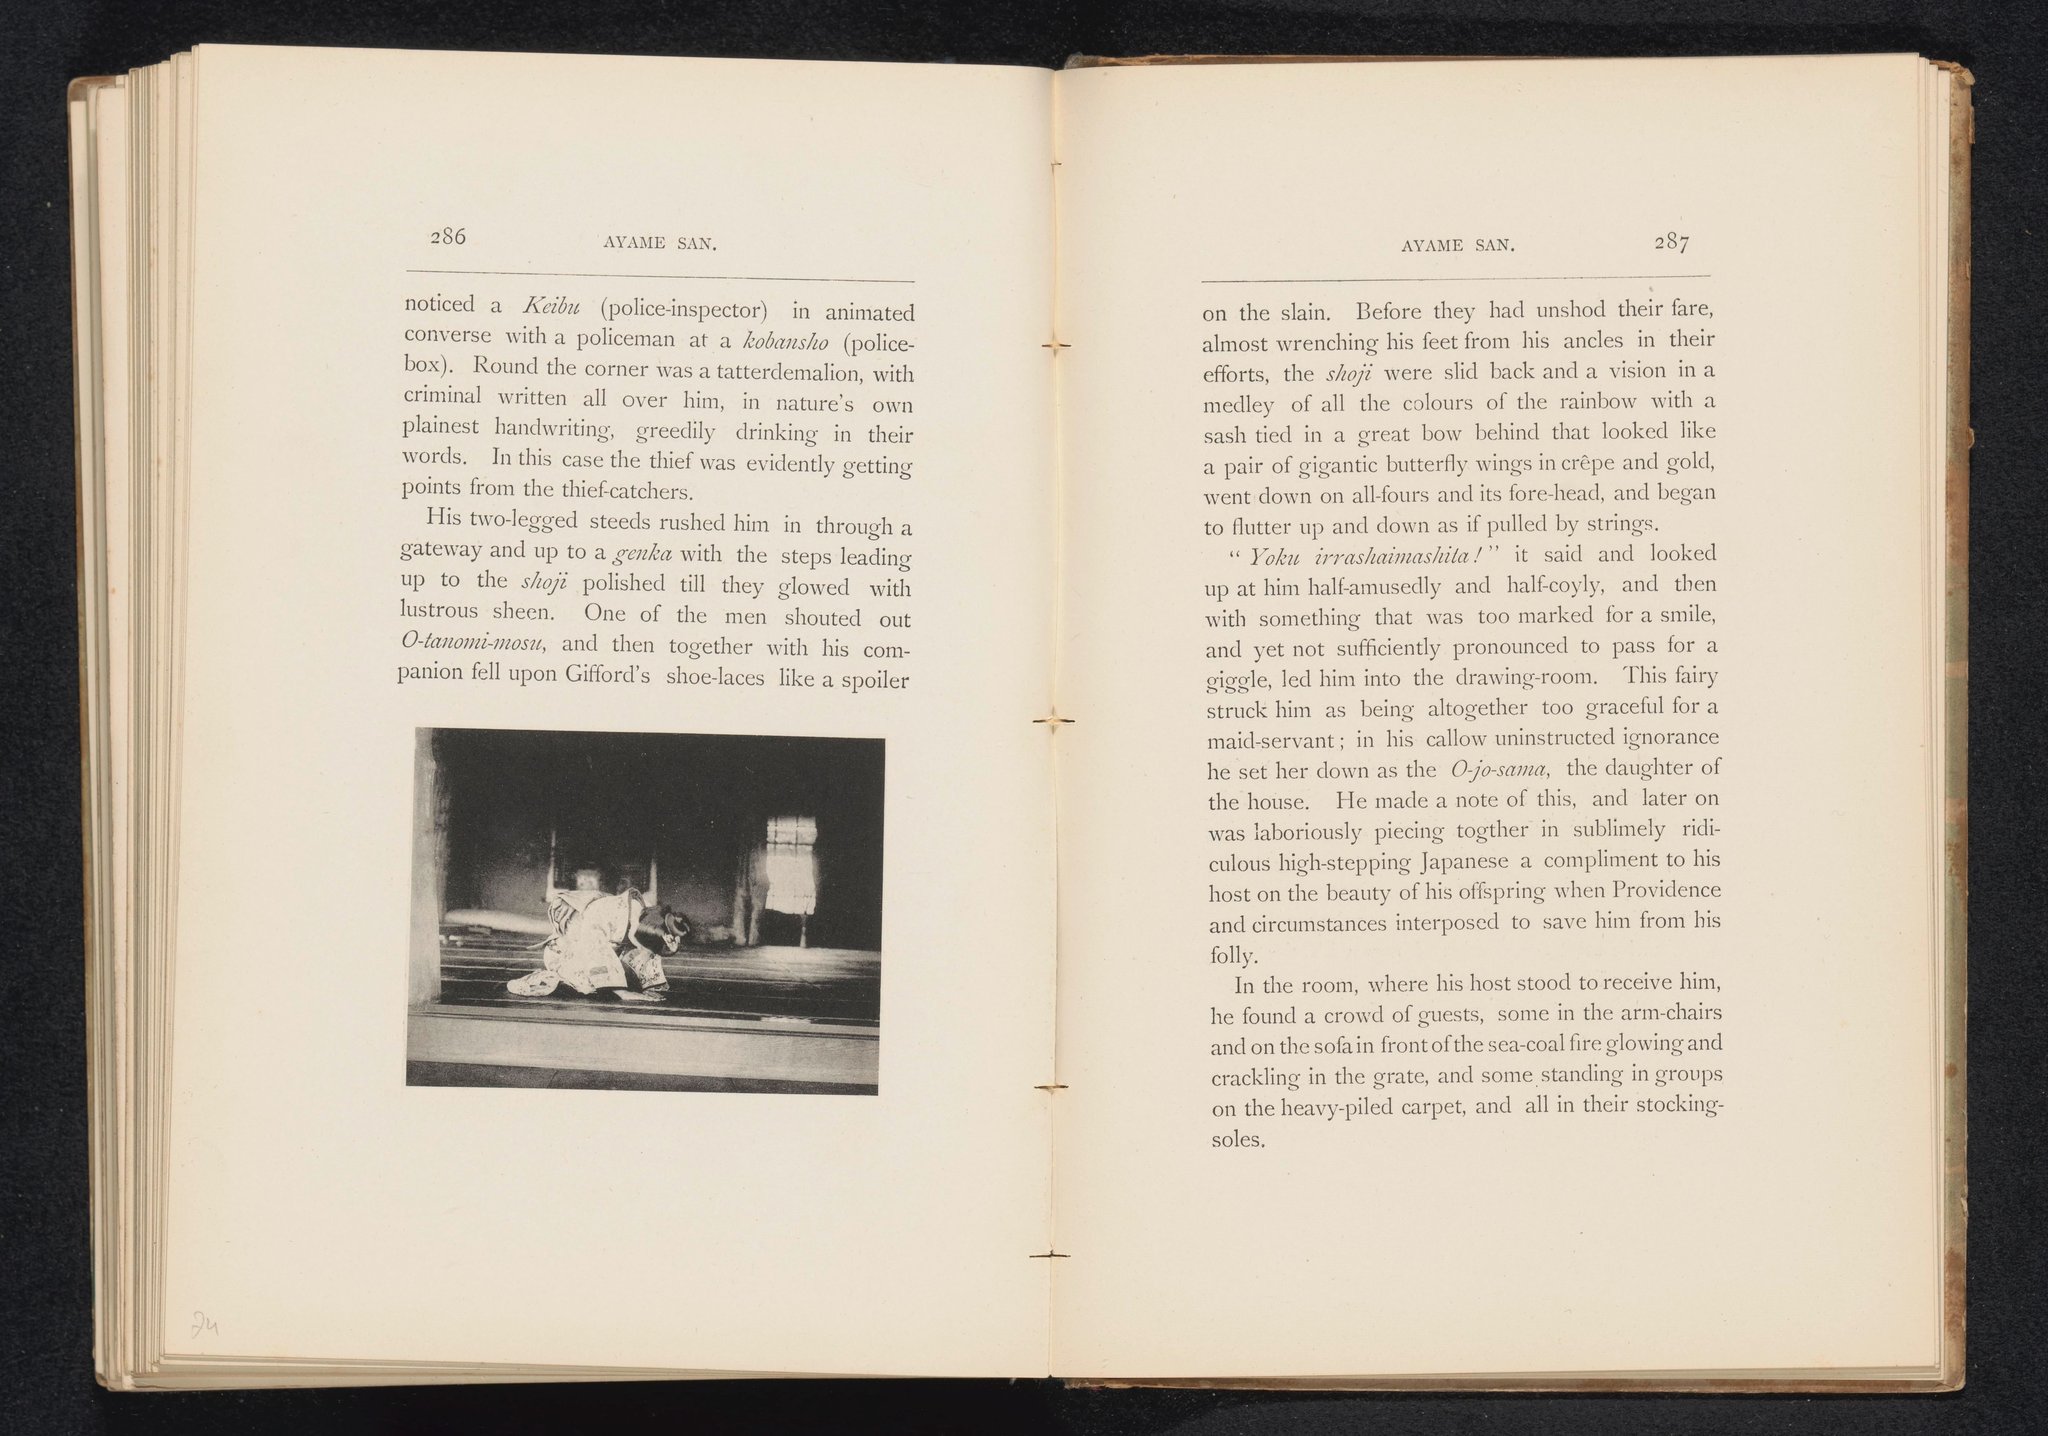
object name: photomechanical print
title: Knielende vrouw in een interieur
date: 1882-1892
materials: paper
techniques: photograph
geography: japan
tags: adult woman, interior ~ representation of a building, kneeling on both knees